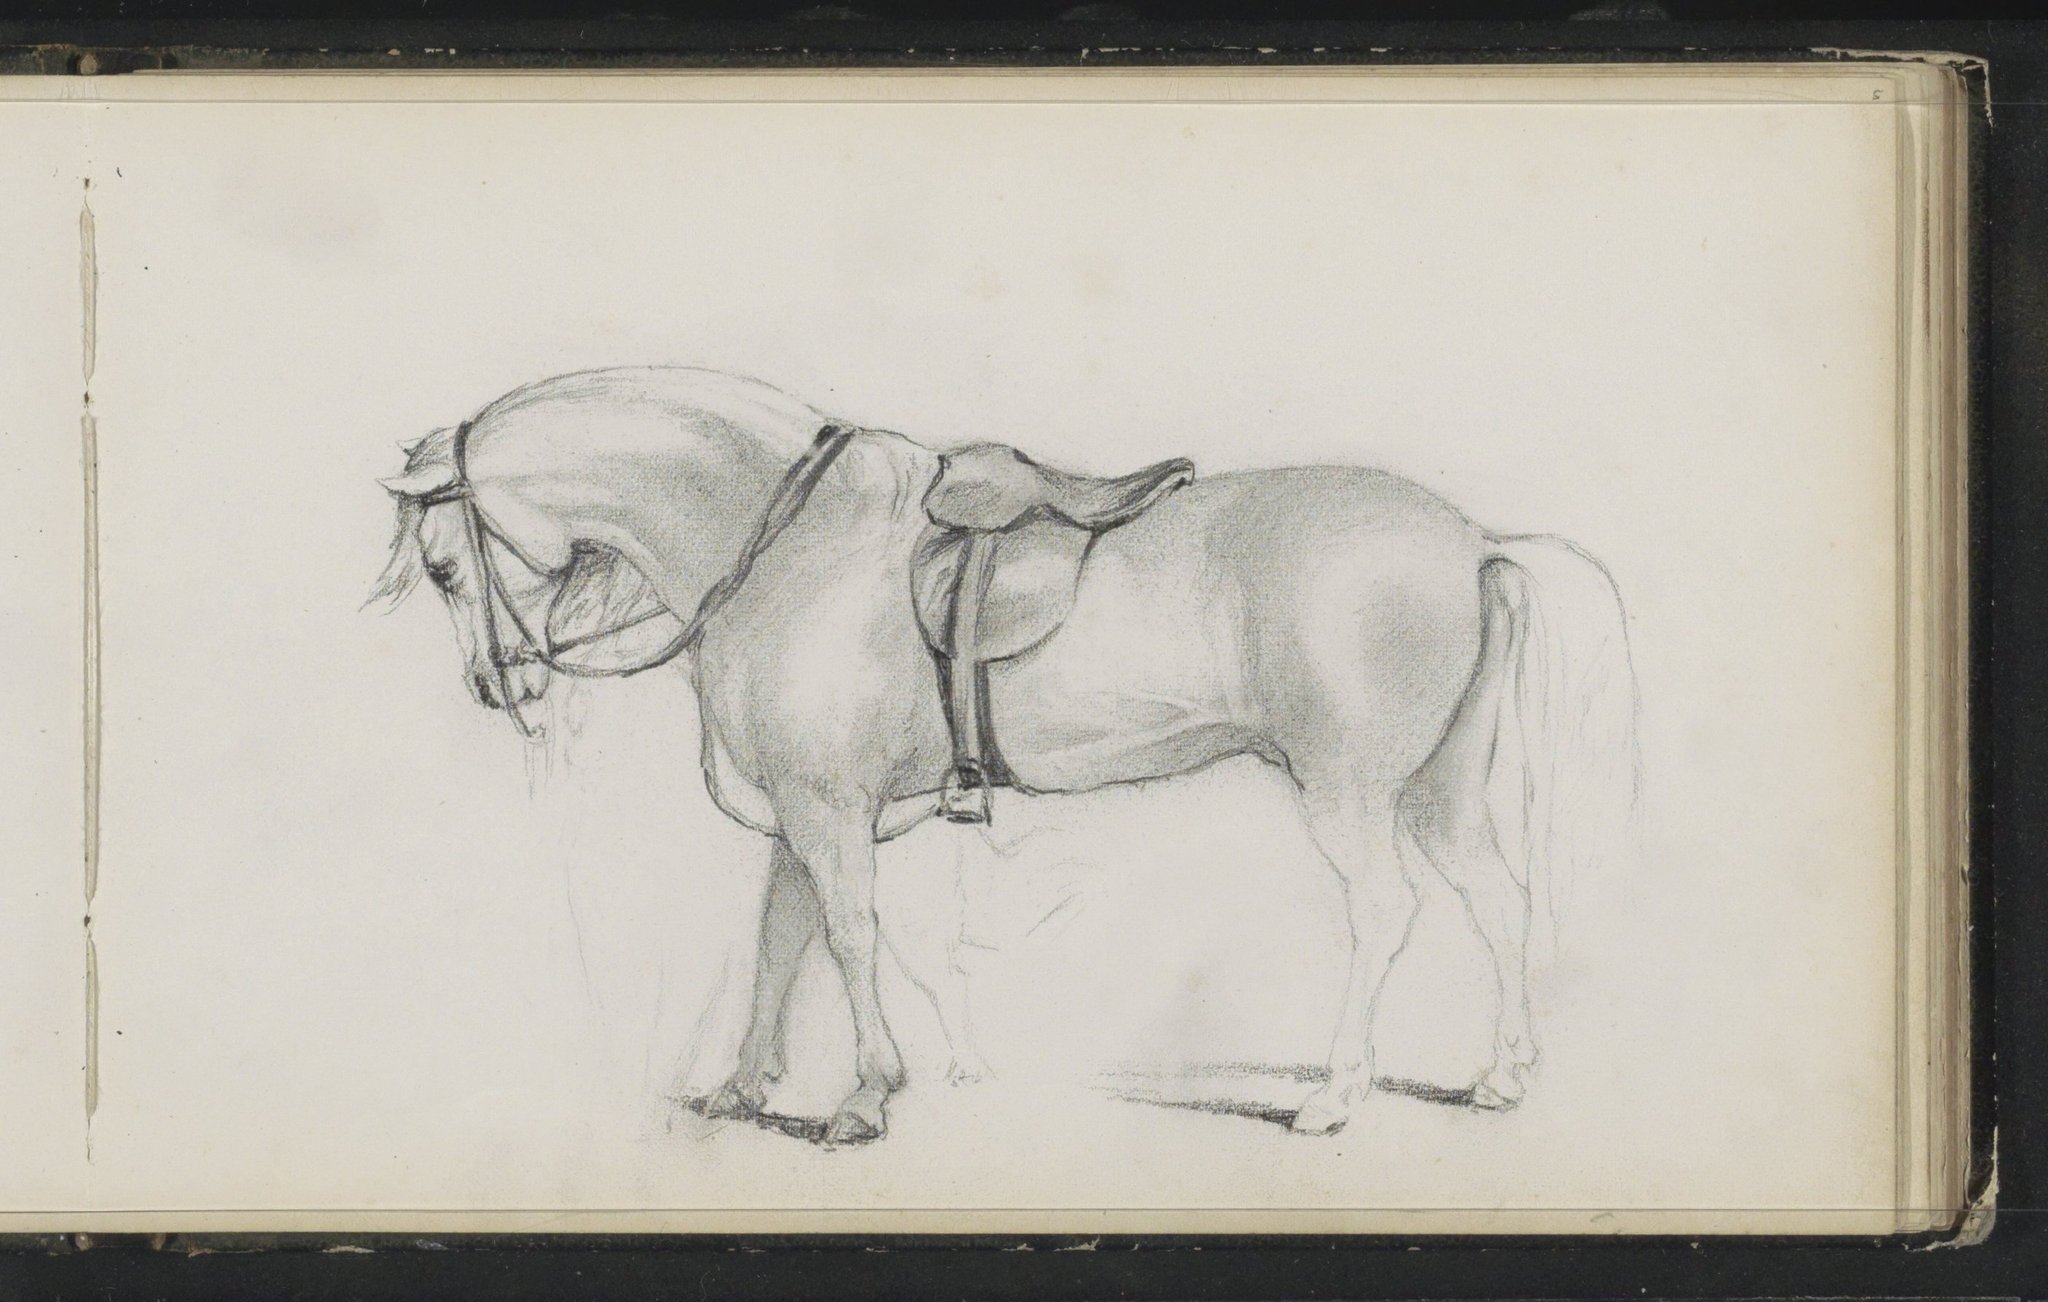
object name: sketchbook leaf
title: Gezadeld paard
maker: marius bauer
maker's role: draughtsman, print maker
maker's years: 1867-1932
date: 1812-1880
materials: paper, pencil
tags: saddle, horse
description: Pagina 5 uit een schetsboek met 34 bladen.